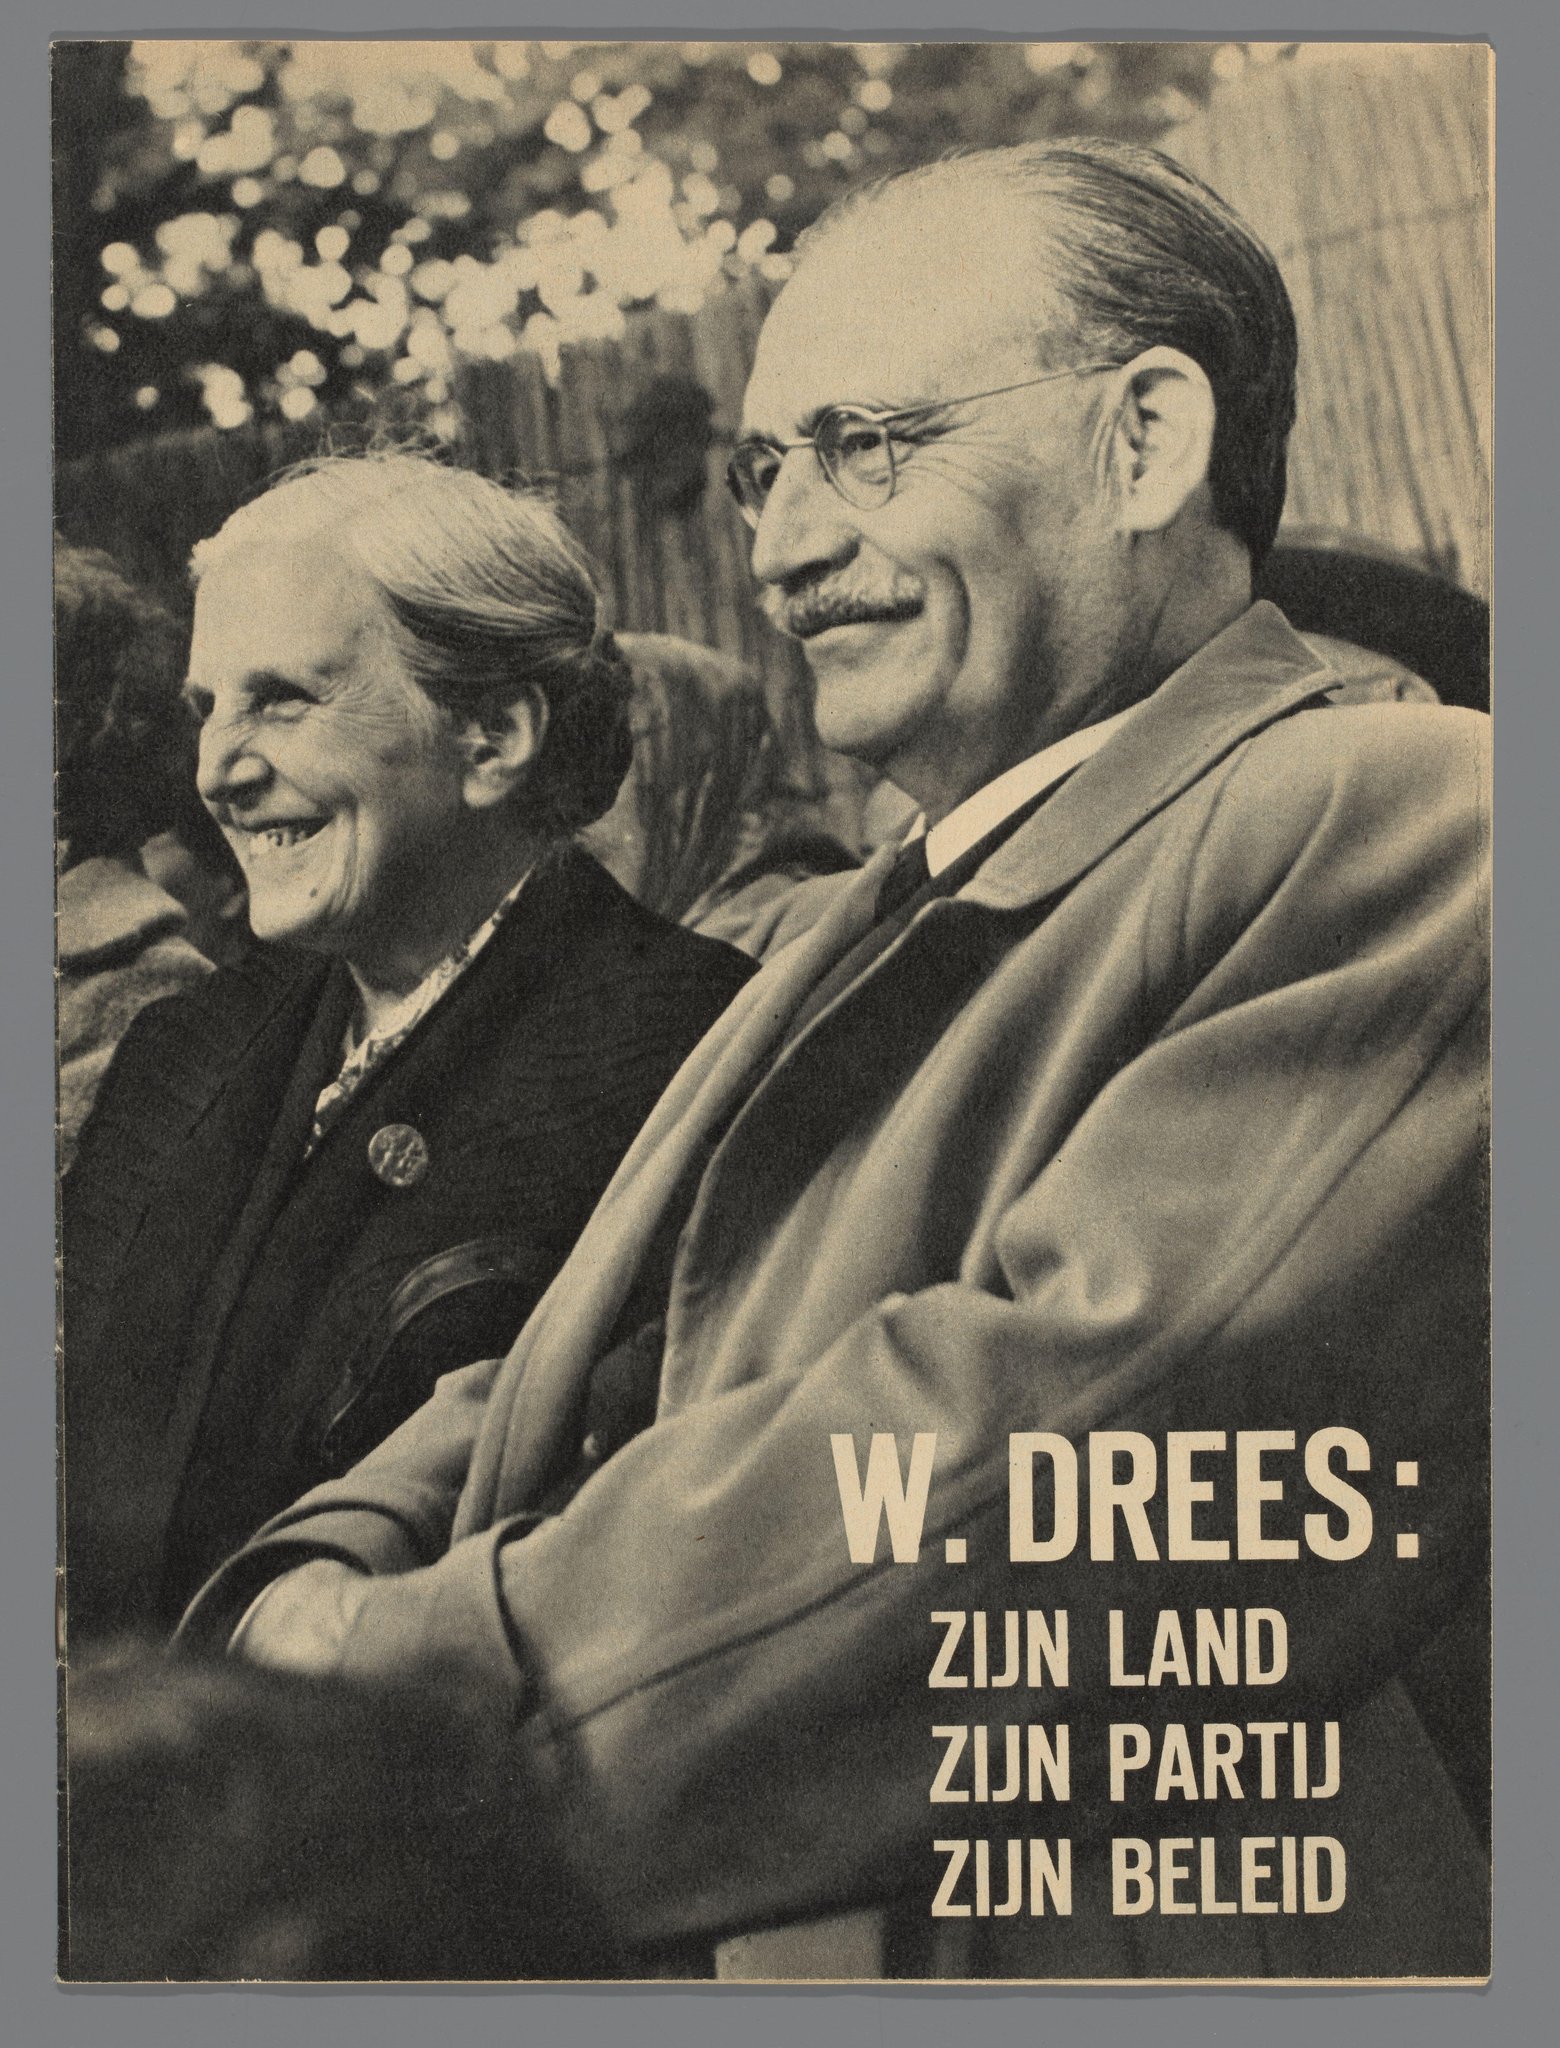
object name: magazine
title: W. Drees: zijn land, zijn partij, zijn beleid. Arbeid, no2 (1955 - 1956)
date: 1956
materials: paper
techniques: printing, stapling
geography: amsterdam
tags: willem drees, netherlands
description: Brochure met 28 zwart-wit foto's. Op de voorzijde foto van een man (W. Drees), borststuk, zittend naast een vrouw (Mevr. Drees). Zestien pagina's. Op de achterzijde een foto van vier wachtende mannen bij een stembureau. Opschrift: W. DREES / ZIJN LAND / ZIJN PARTIJ / ZIJN BELEID.